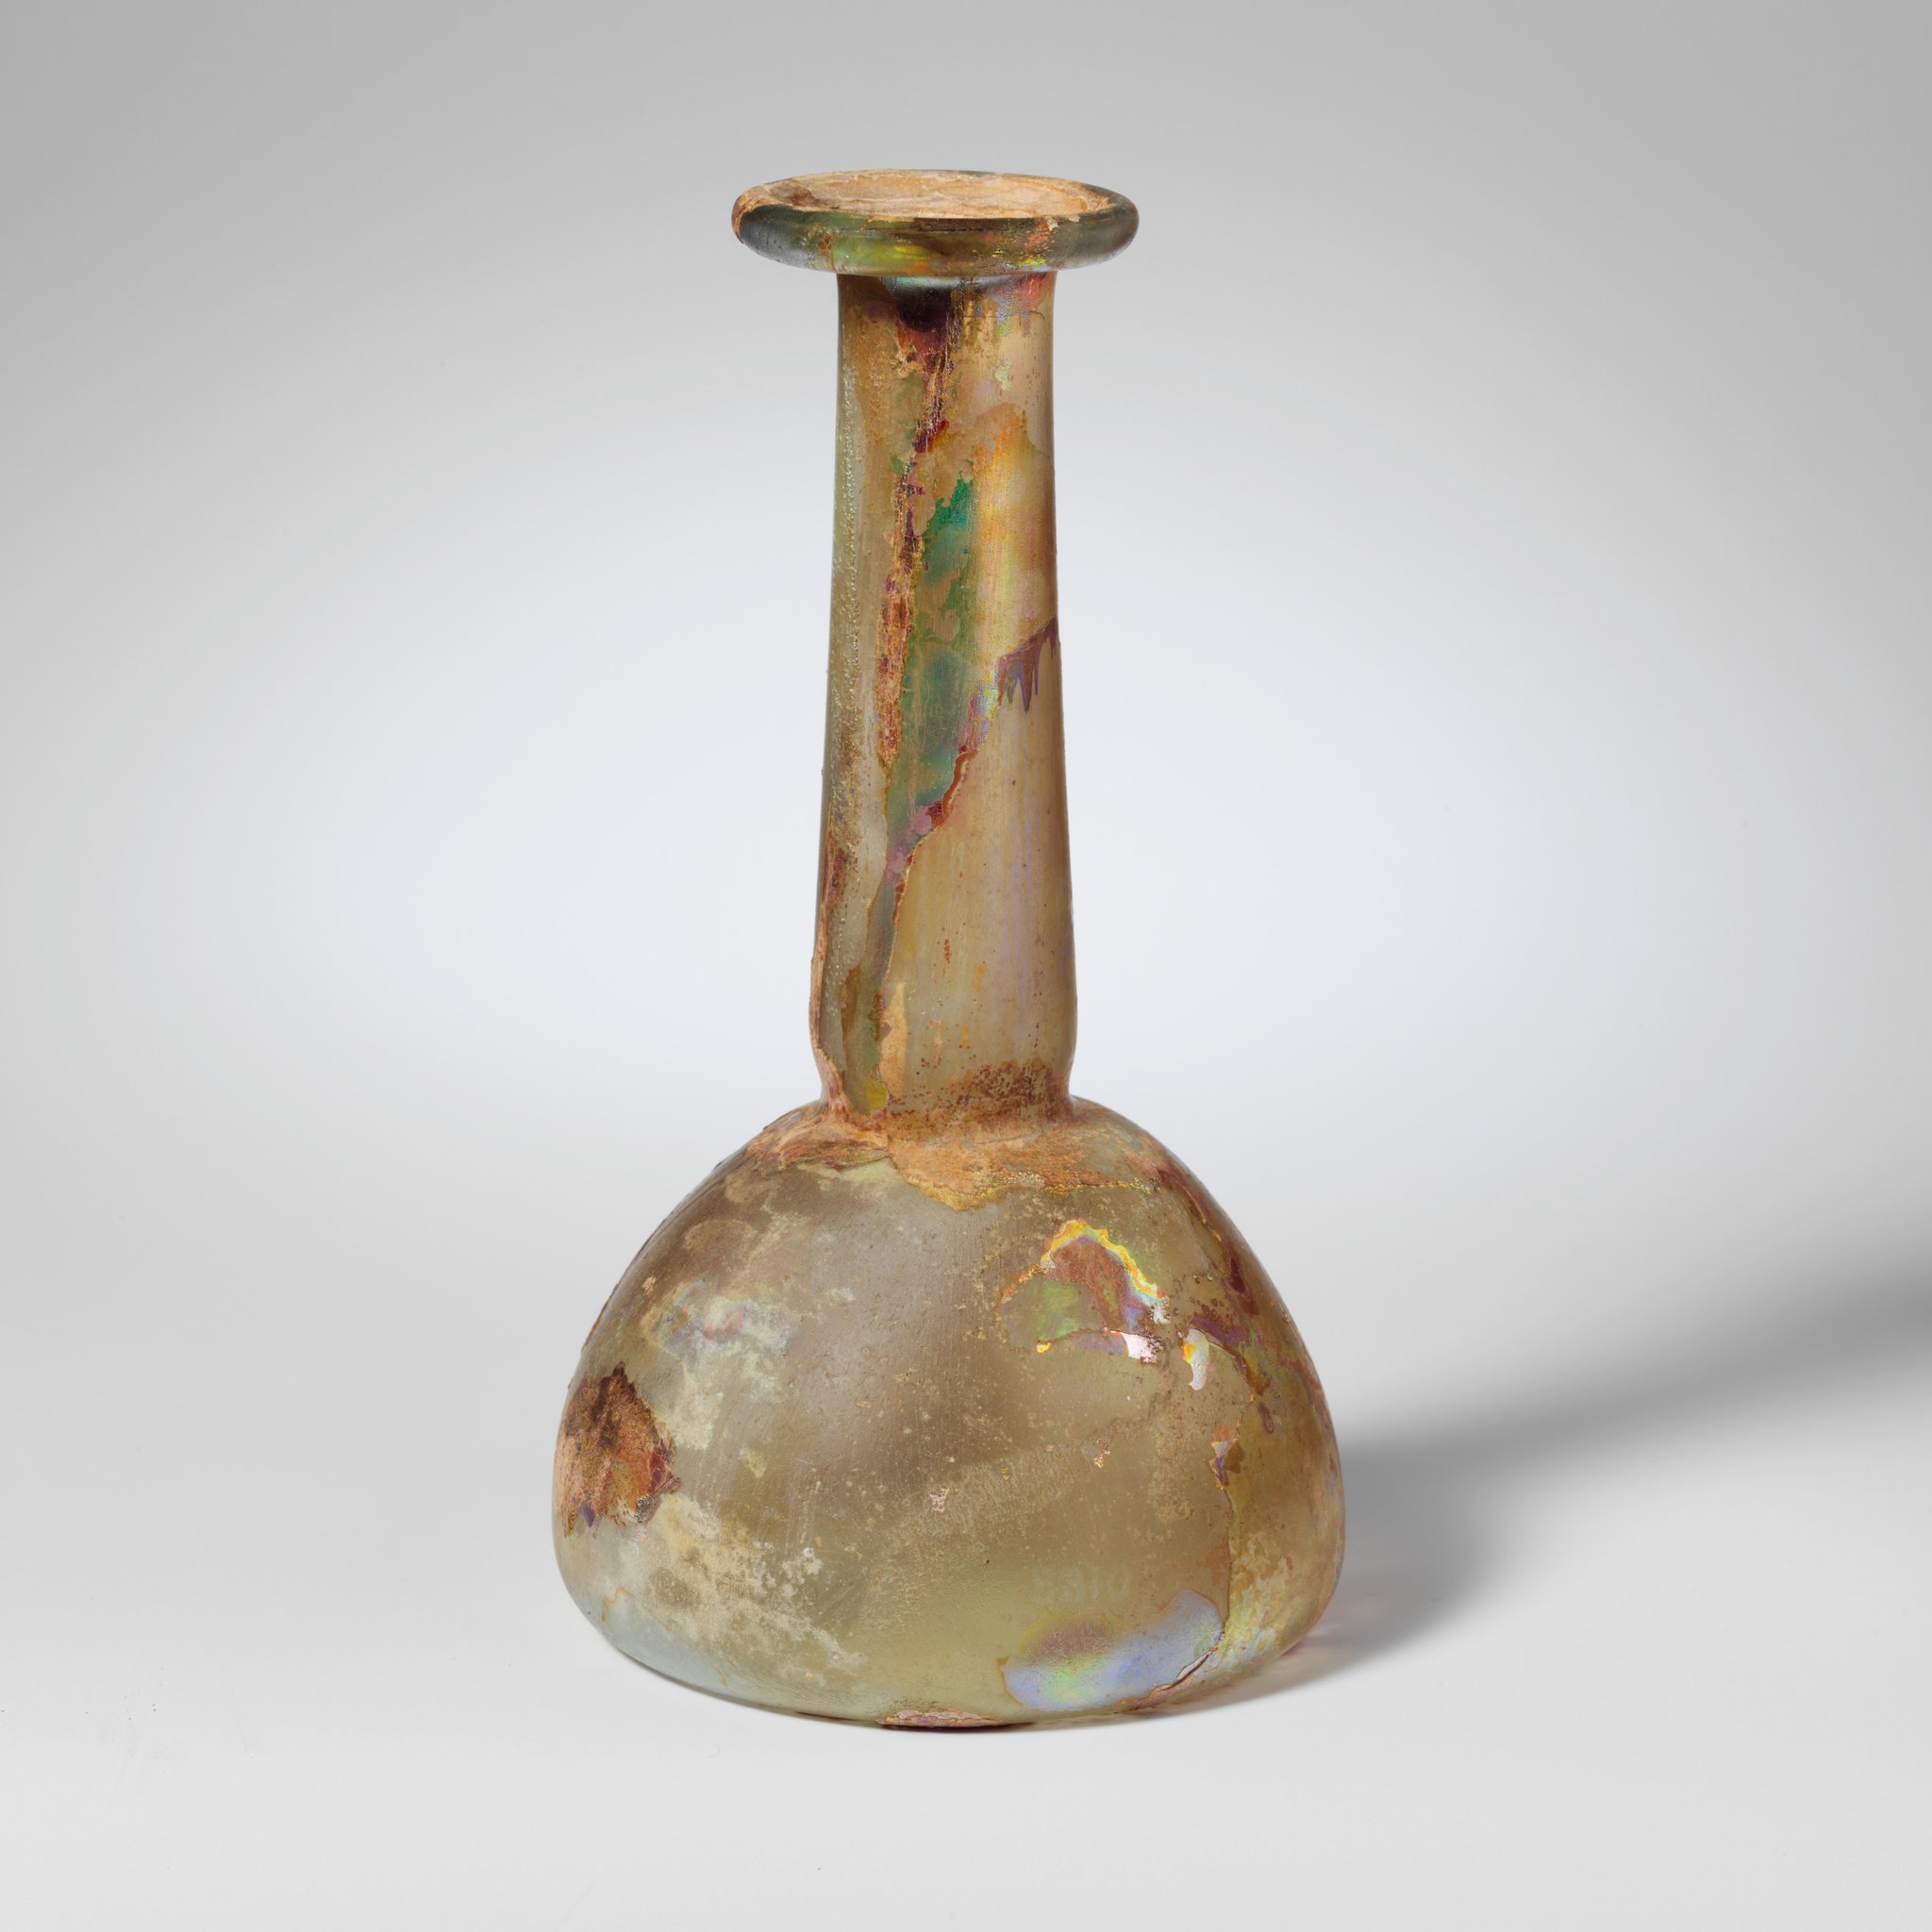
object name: perfume bottle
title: Glass perfume bottle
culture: roman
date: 67-166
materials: glass